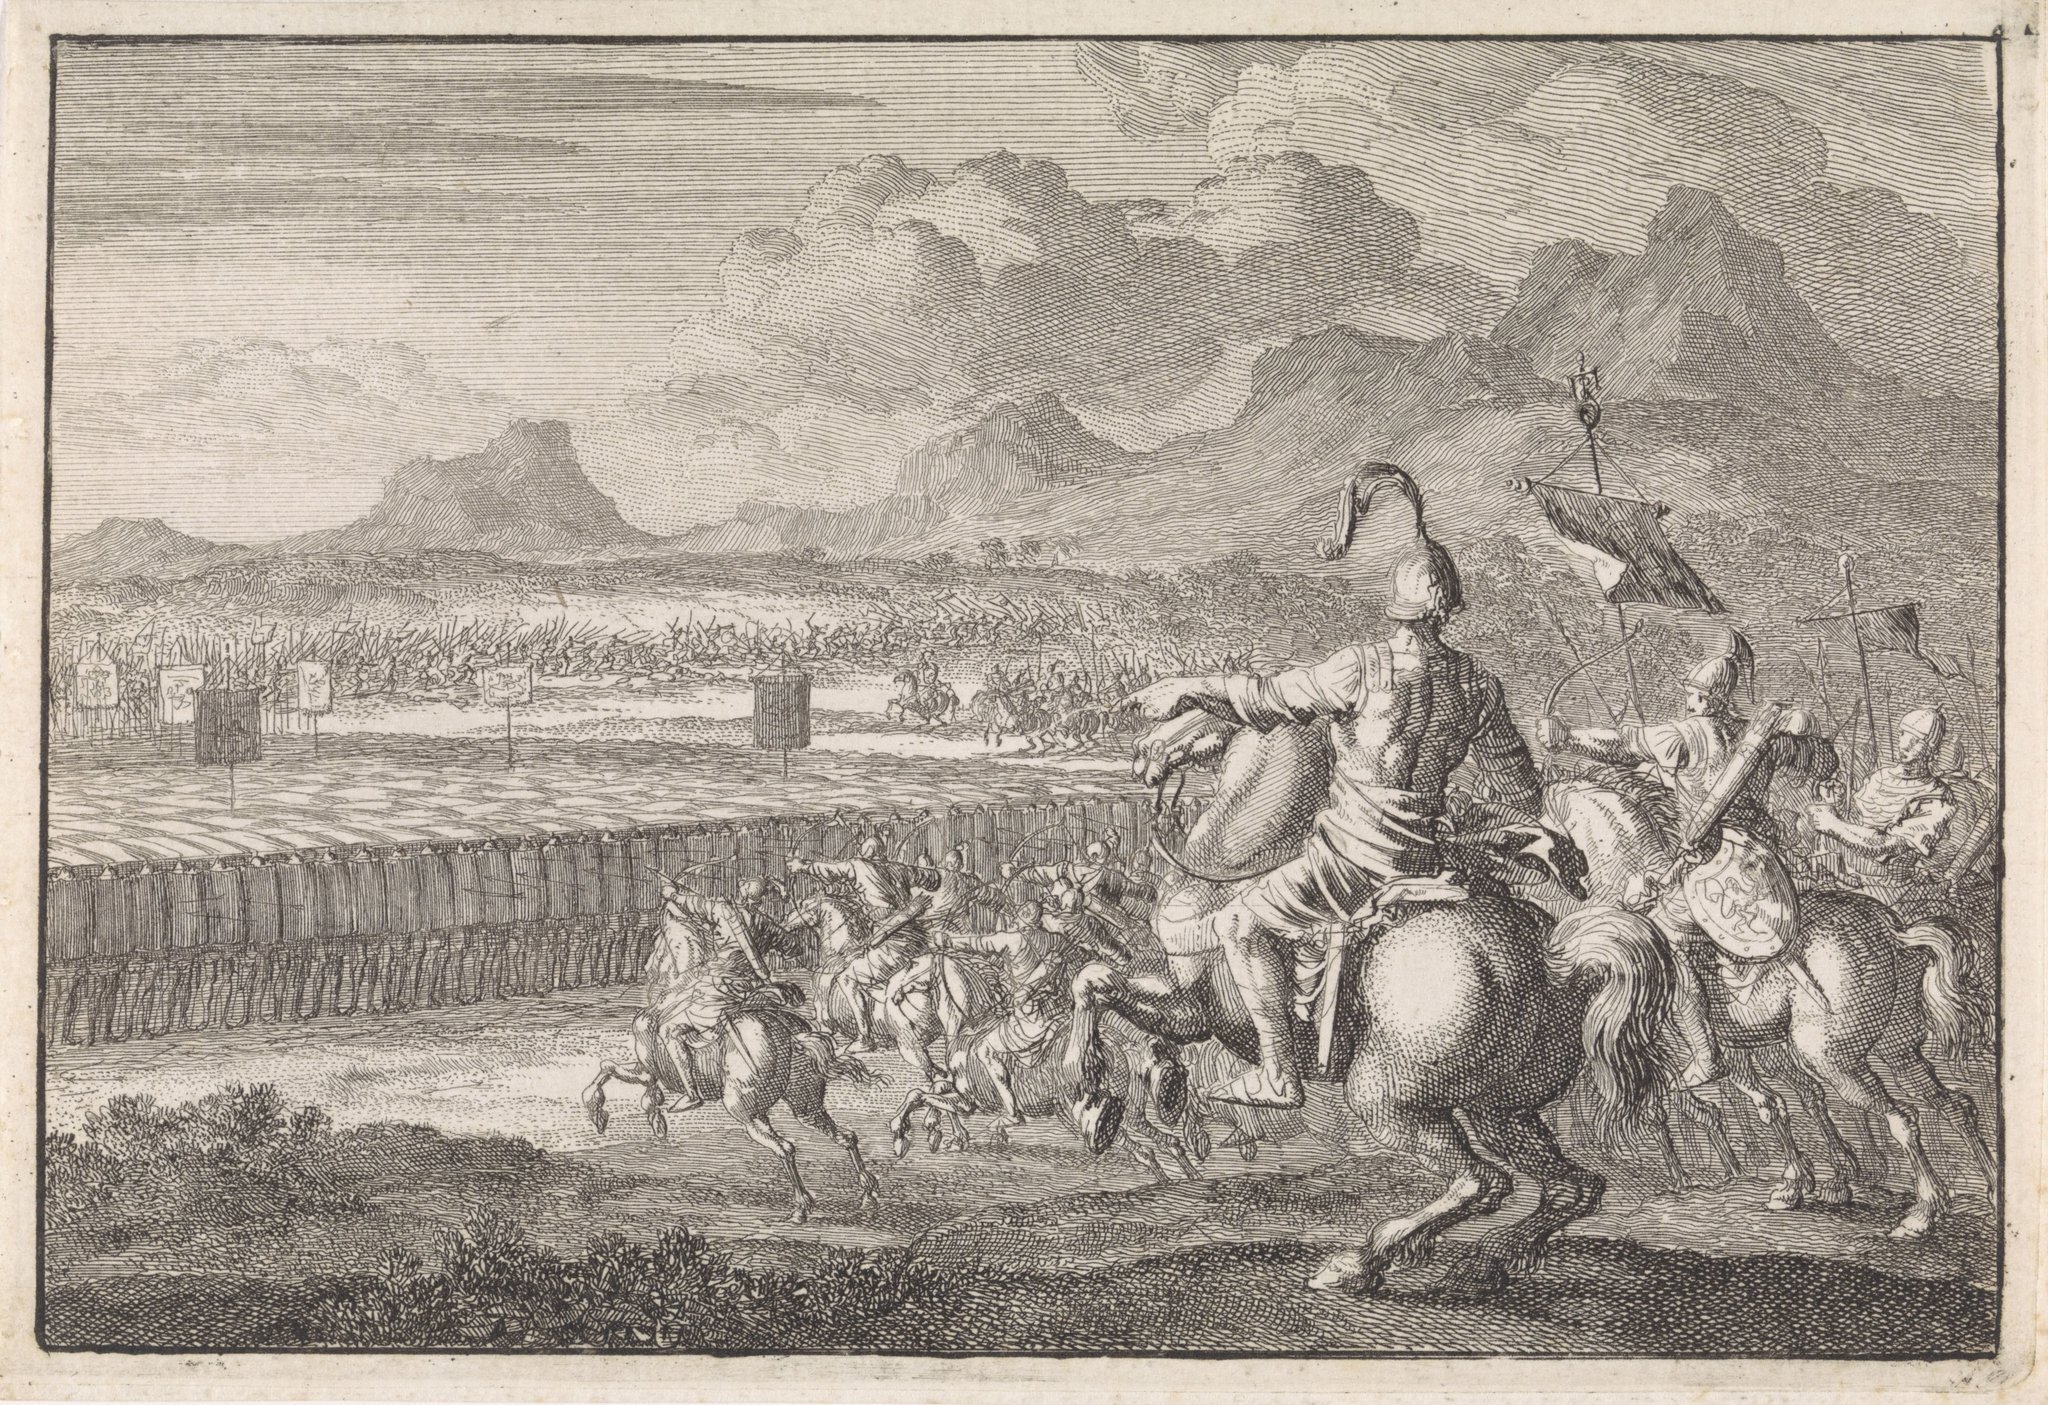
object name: print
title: Slag van Joppe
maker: jan luyken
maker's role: draughtsman, print maker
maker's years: 1649-1712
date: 1704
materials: paper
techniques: etching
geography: amsterdam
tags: battle of the maccabees against apollonius, governor of coelesyria (1 maccabees 10:74-85)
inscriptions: collector's mark: Lugt 2228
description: Prent ook gebruikt als boekillustratie in: Josephus, Flavius. Alle de Werken, 2 delen. Amsterdam: Pieter Mortier, 1704, dl. 1, p. 312.